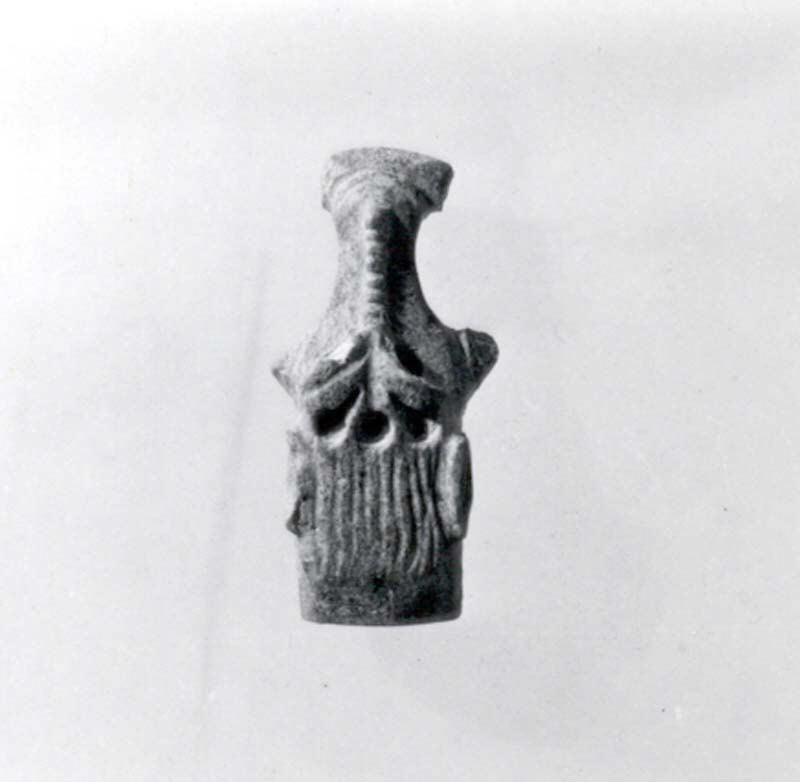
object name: necklace, bead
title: Amulet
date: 100-1 BCE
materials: lapis lazuli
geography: indus region